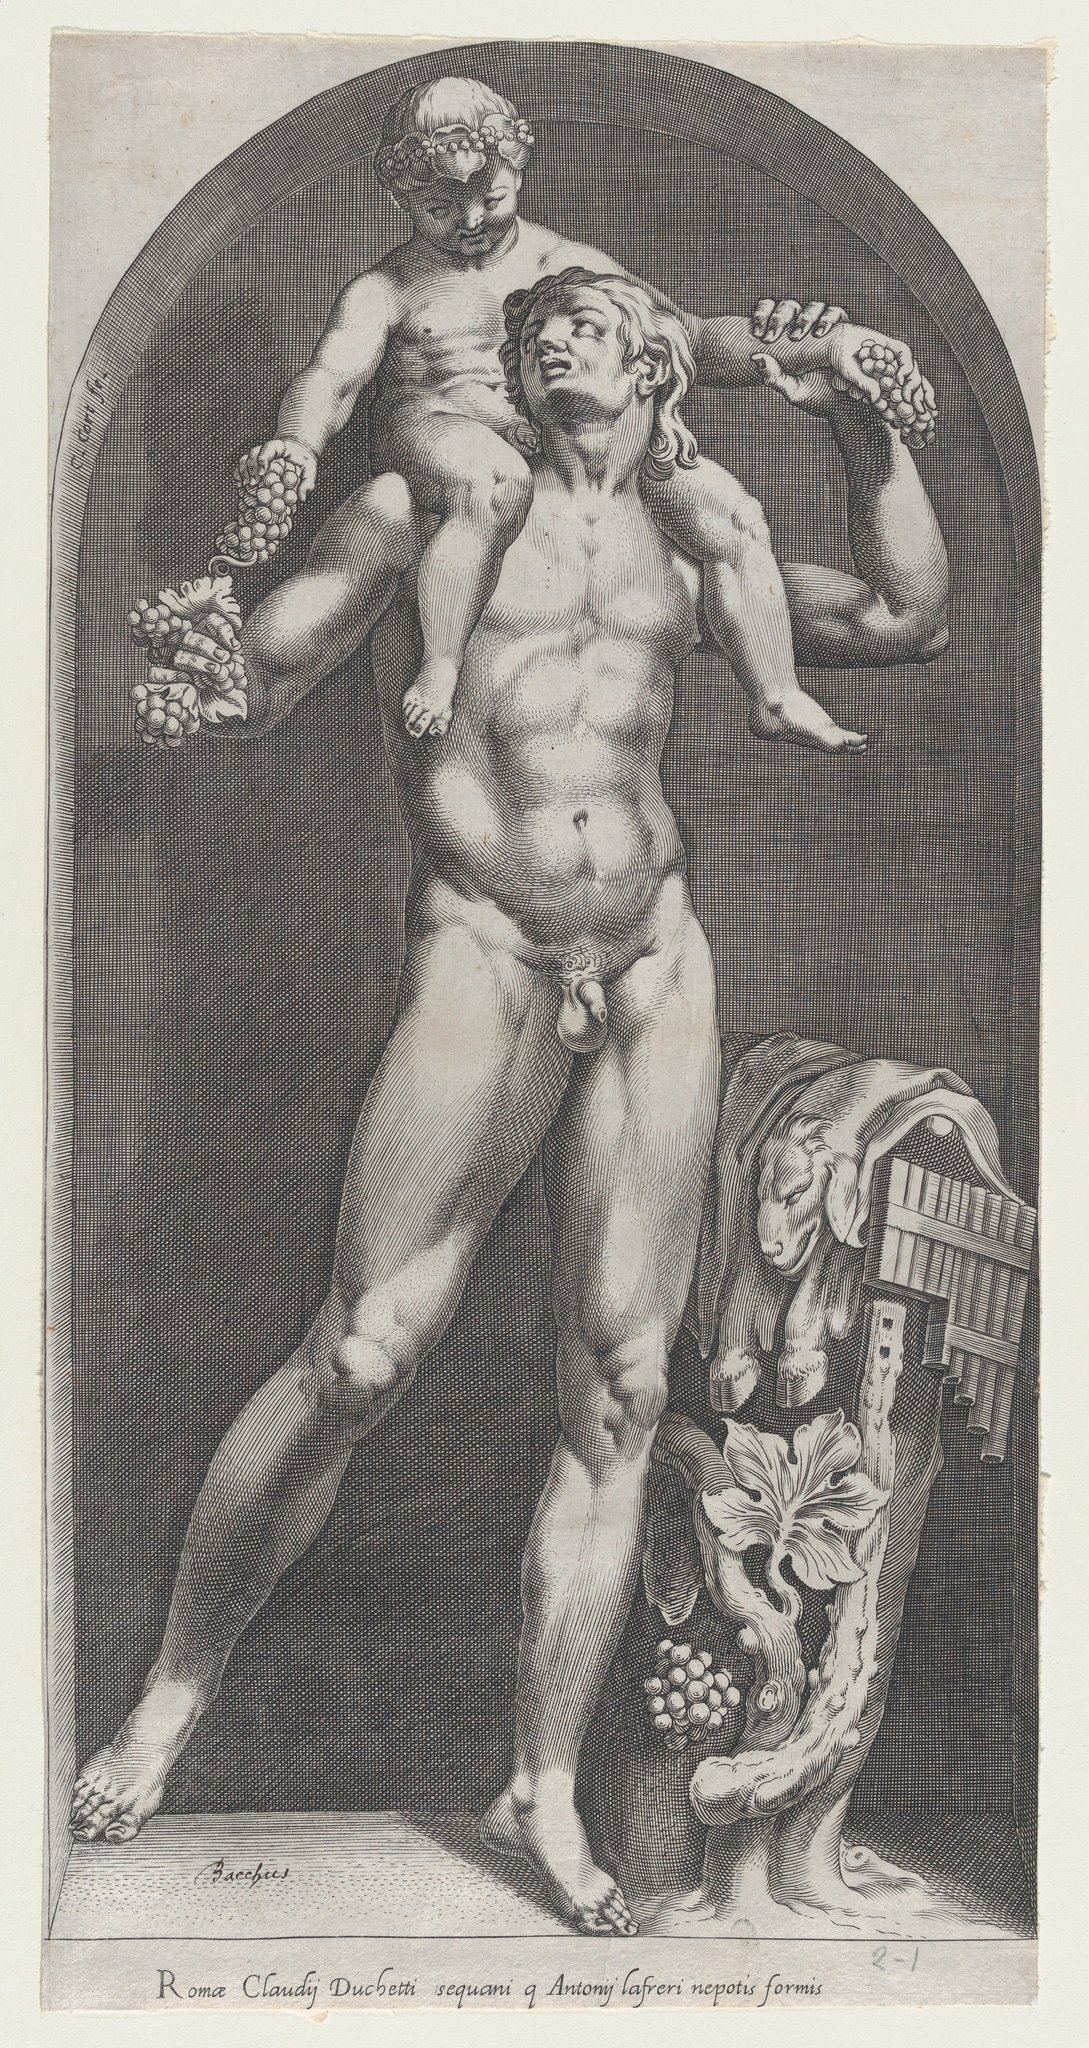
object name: print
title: Bacchus on the Shoulders of a Satyr, from "Speculum Romanae Magnificentiae"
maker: cornelis cort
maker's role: artist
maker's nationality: netherlandish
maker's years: 1533-1578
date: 1501-1600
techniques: engraving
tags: bacchus,satyrs